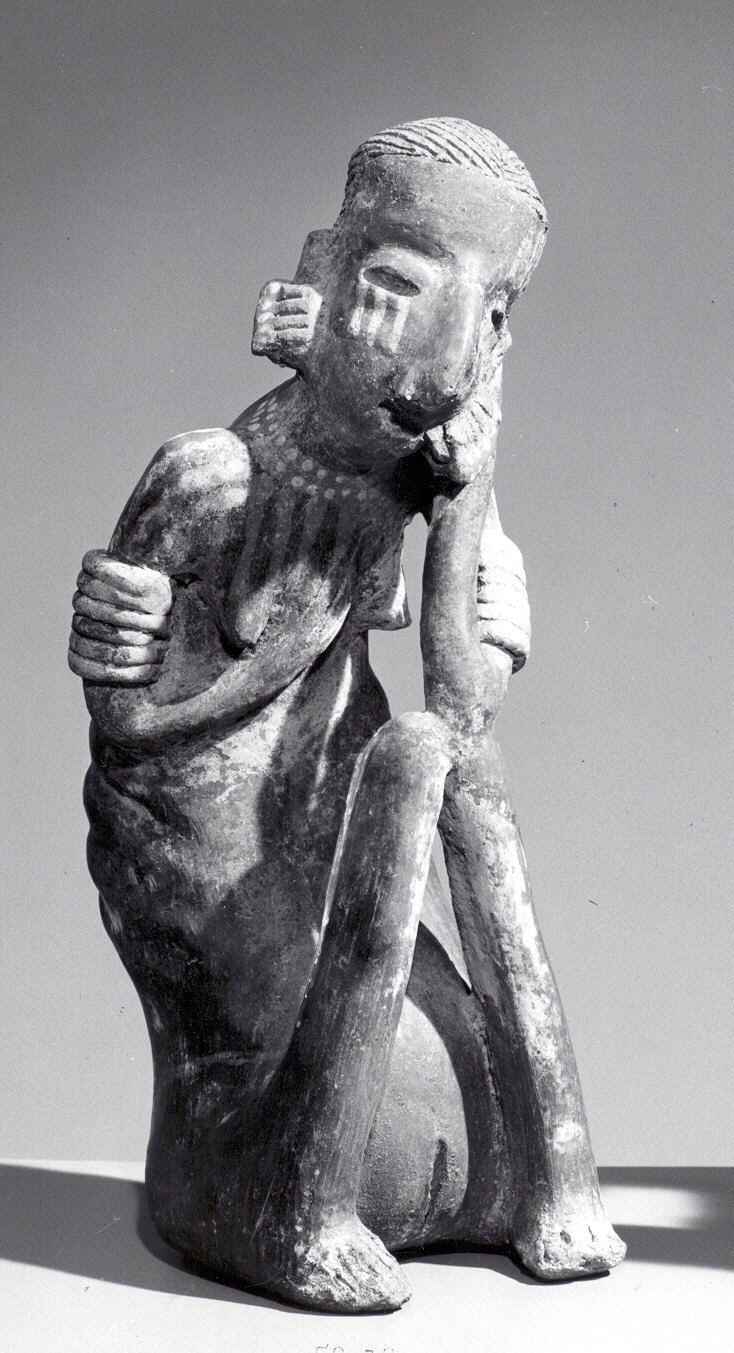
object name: female figure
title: Figure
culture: nayarit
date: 101-300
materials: ceramic, pigment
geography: mexico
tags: human figures